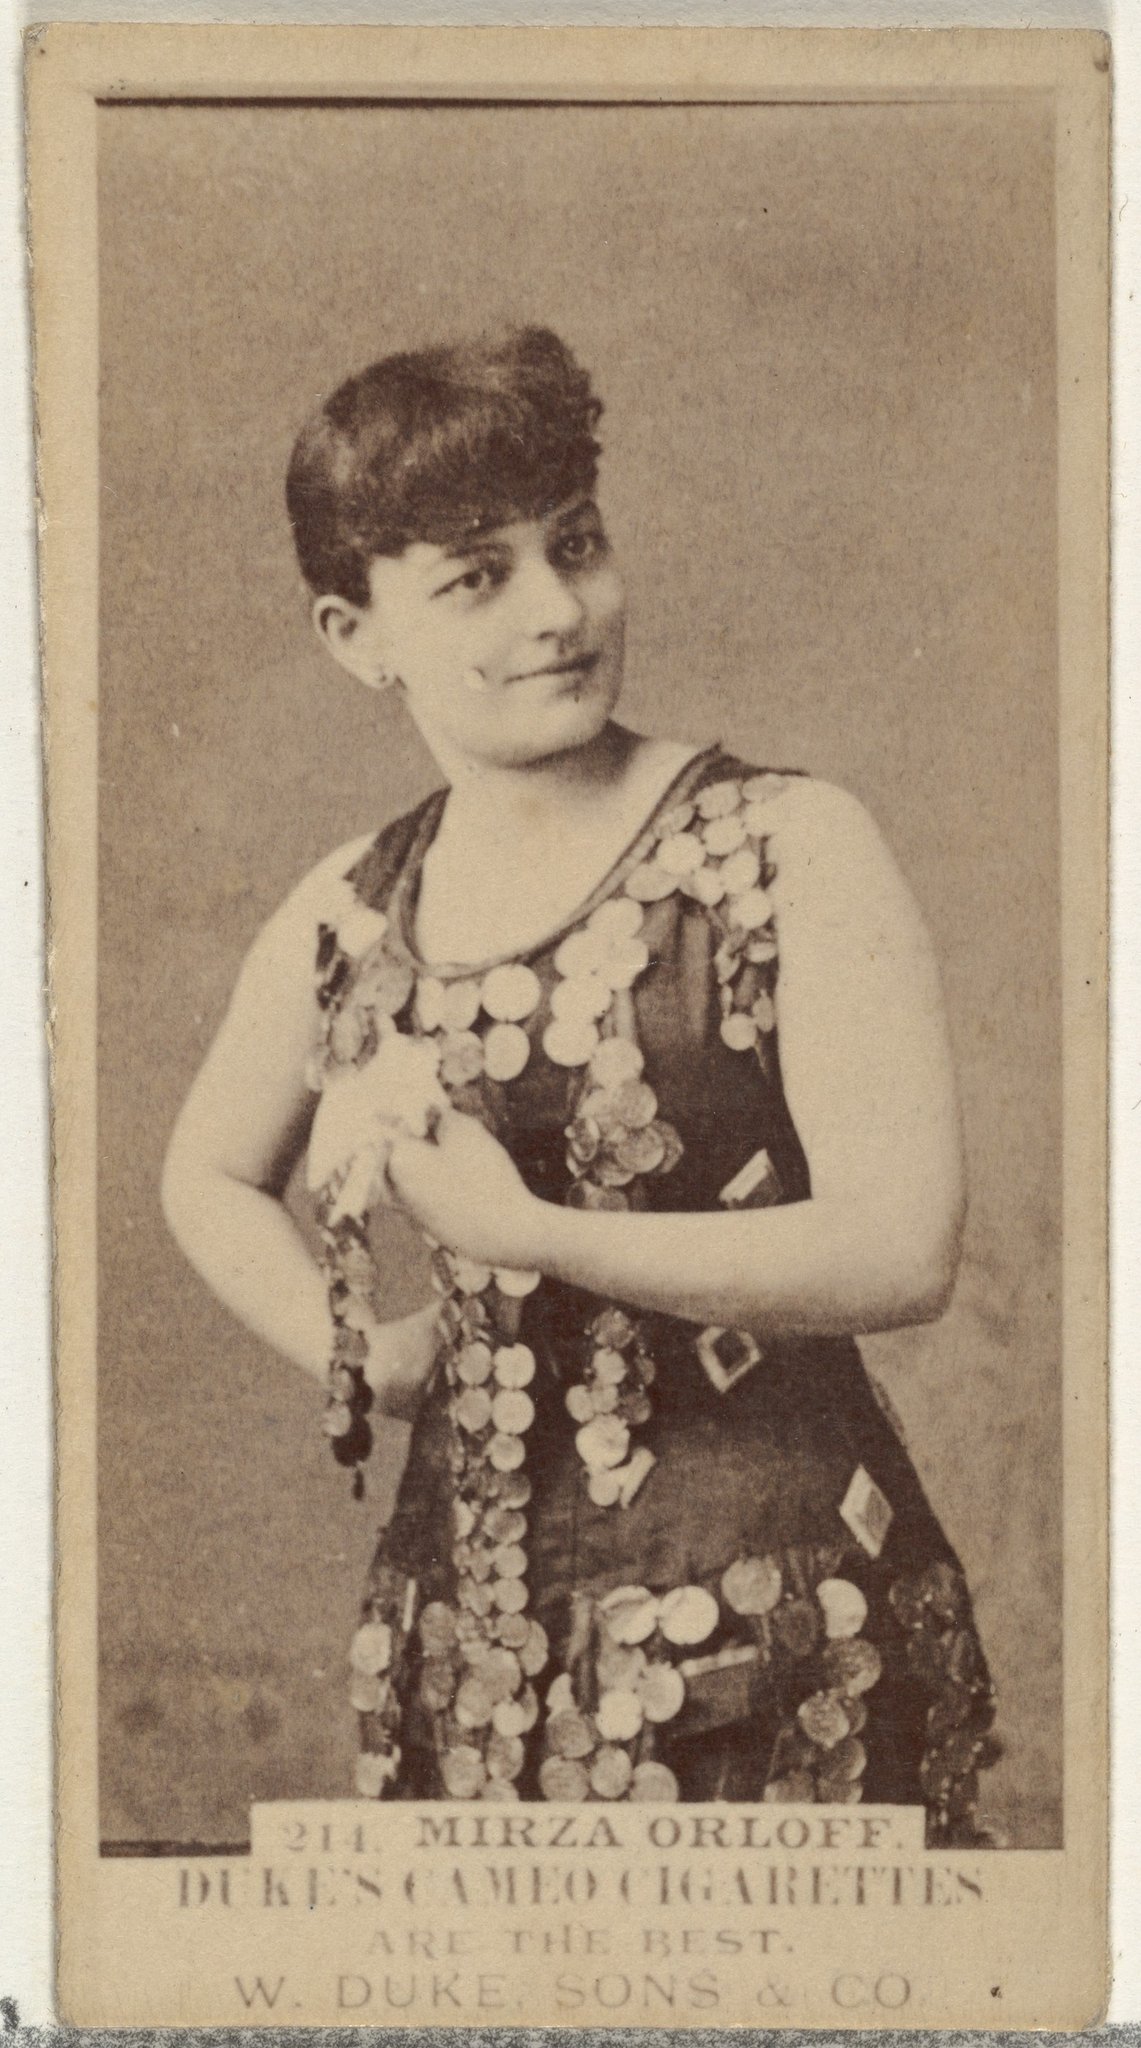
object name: photograph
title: Card Number 214, Mirza Orloff, from the Actors and Actresses series (N145-5) issued by Duke Sons & Co. to promote Cameo Cigarettes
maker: w. duke, sons & co.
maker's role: publisher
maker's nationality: american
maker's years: 1870-1920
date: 1880-1889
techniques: albumen silver print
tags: portraits,women,actresses